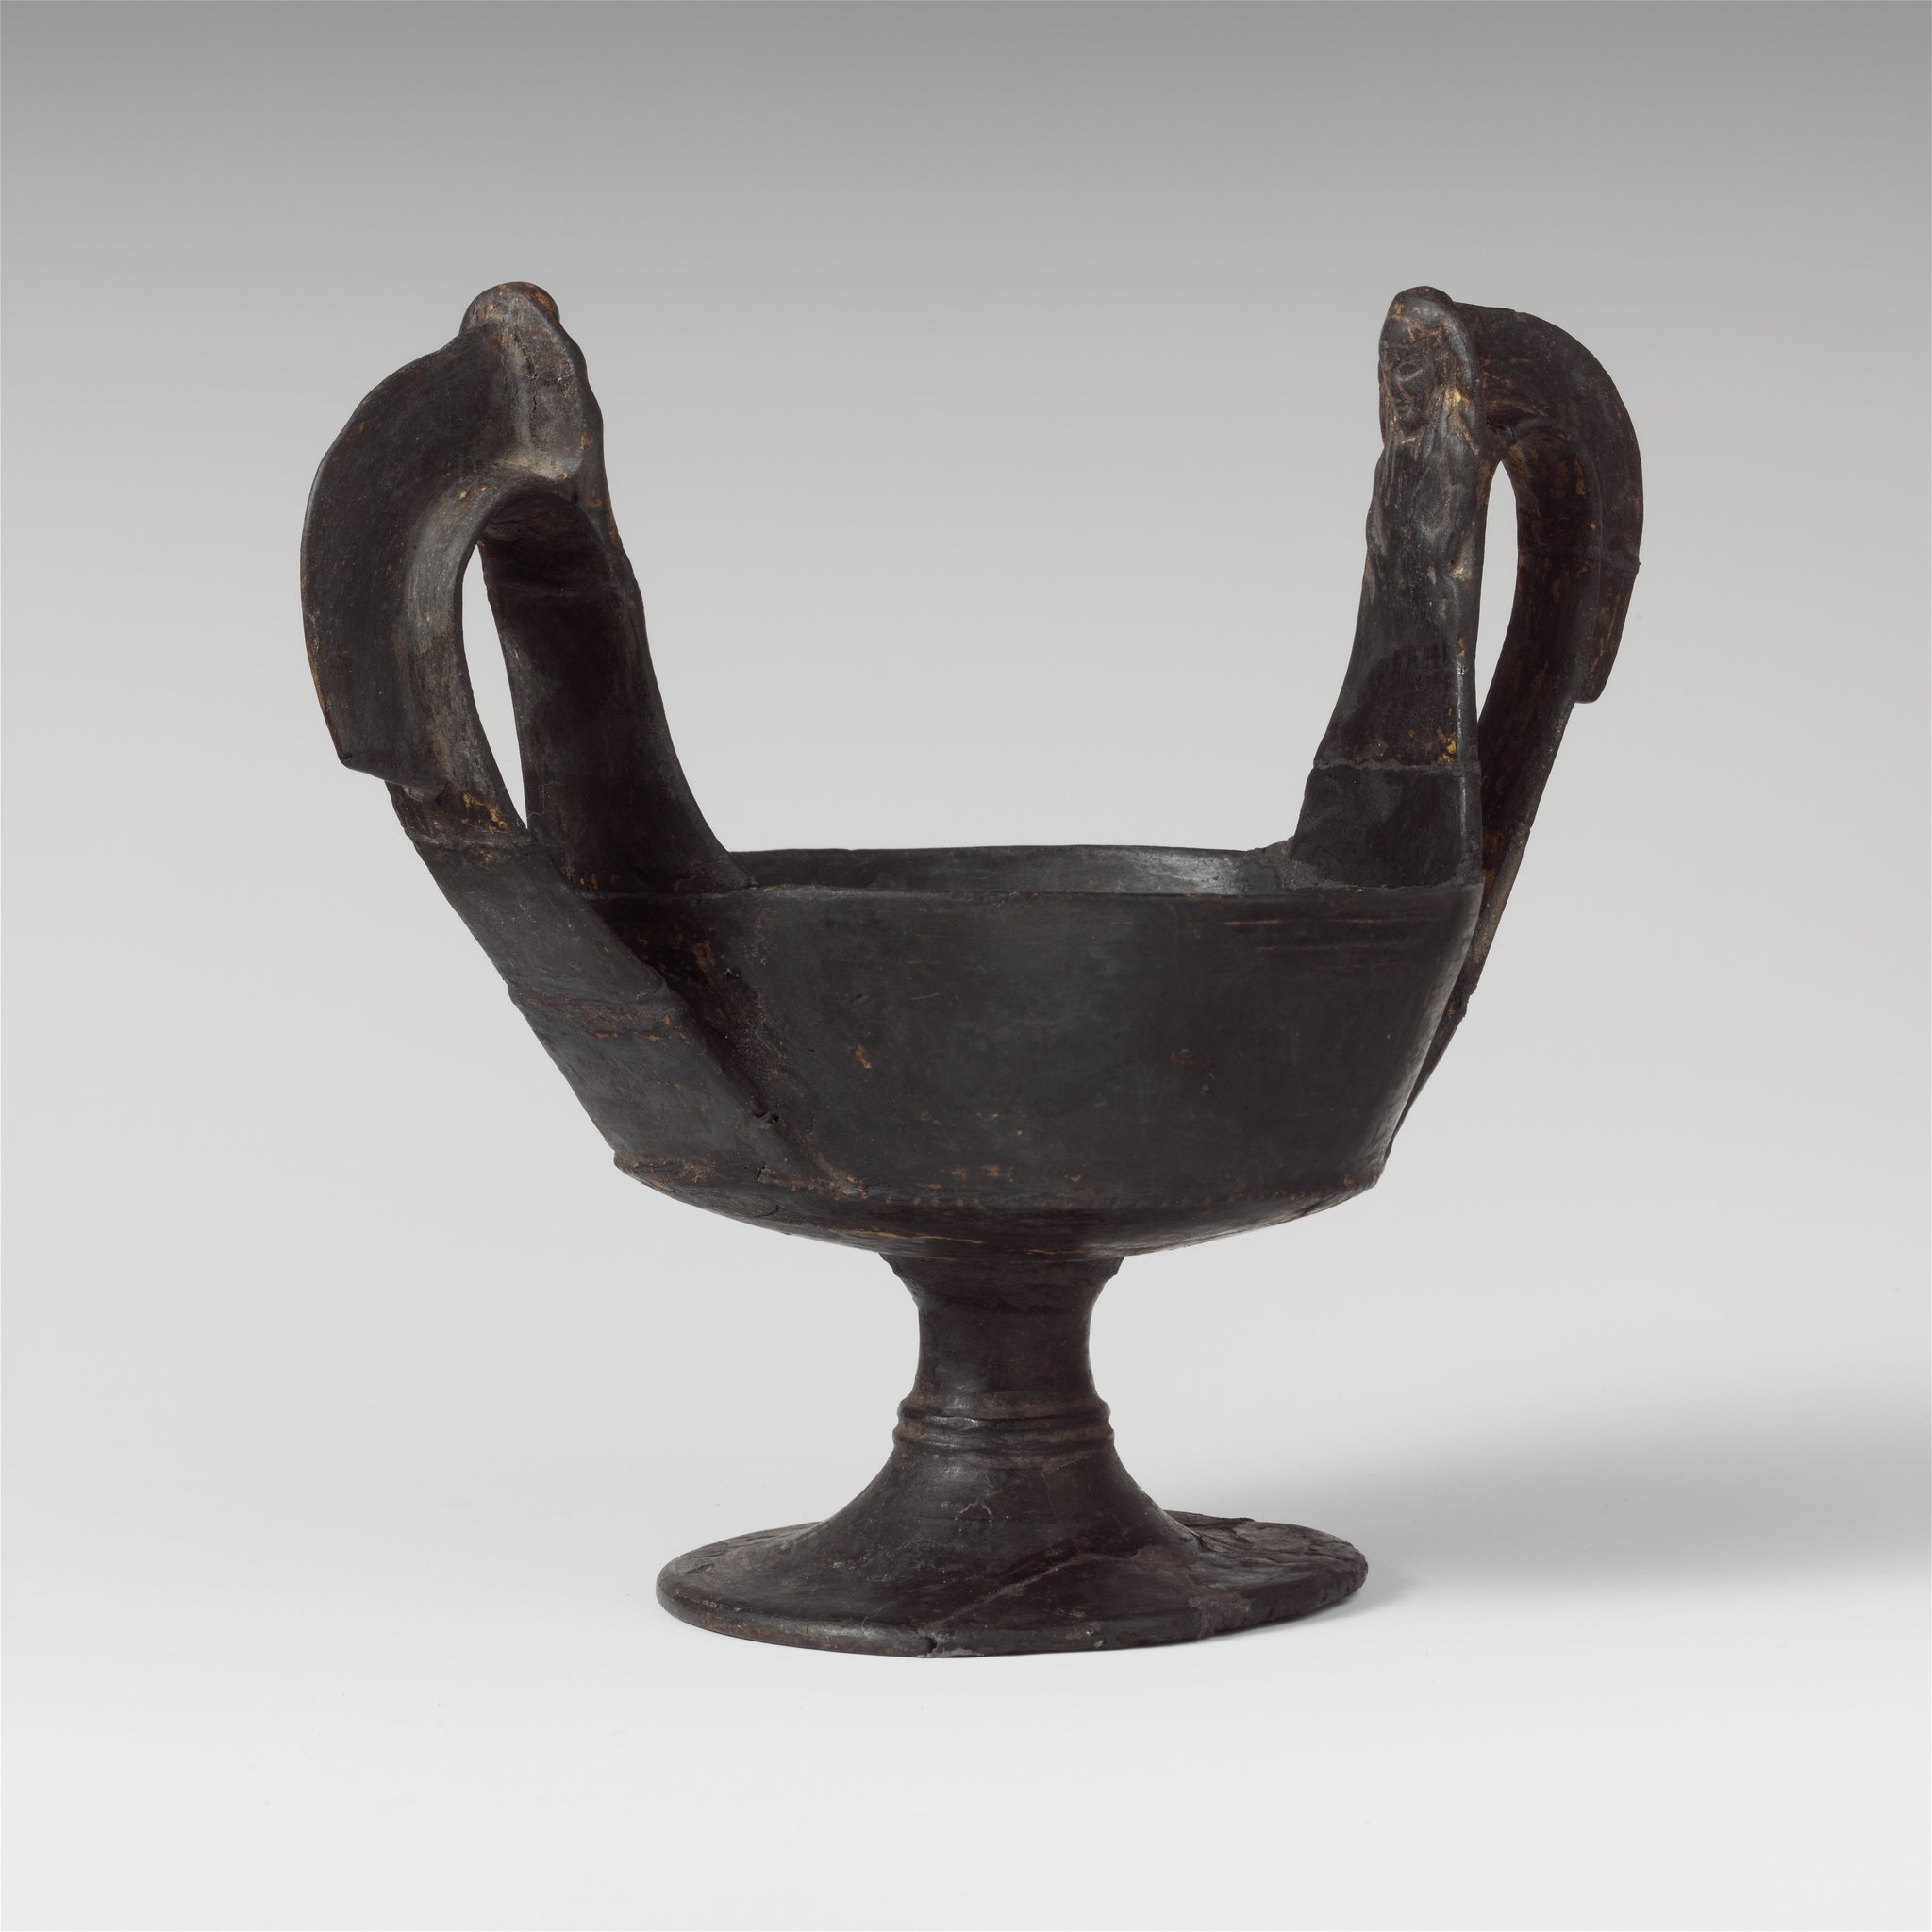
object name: kantharos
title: Terracotta kantharos (drinking cup with high handles)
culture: etruscan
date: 600-501 BCE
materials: terracotta